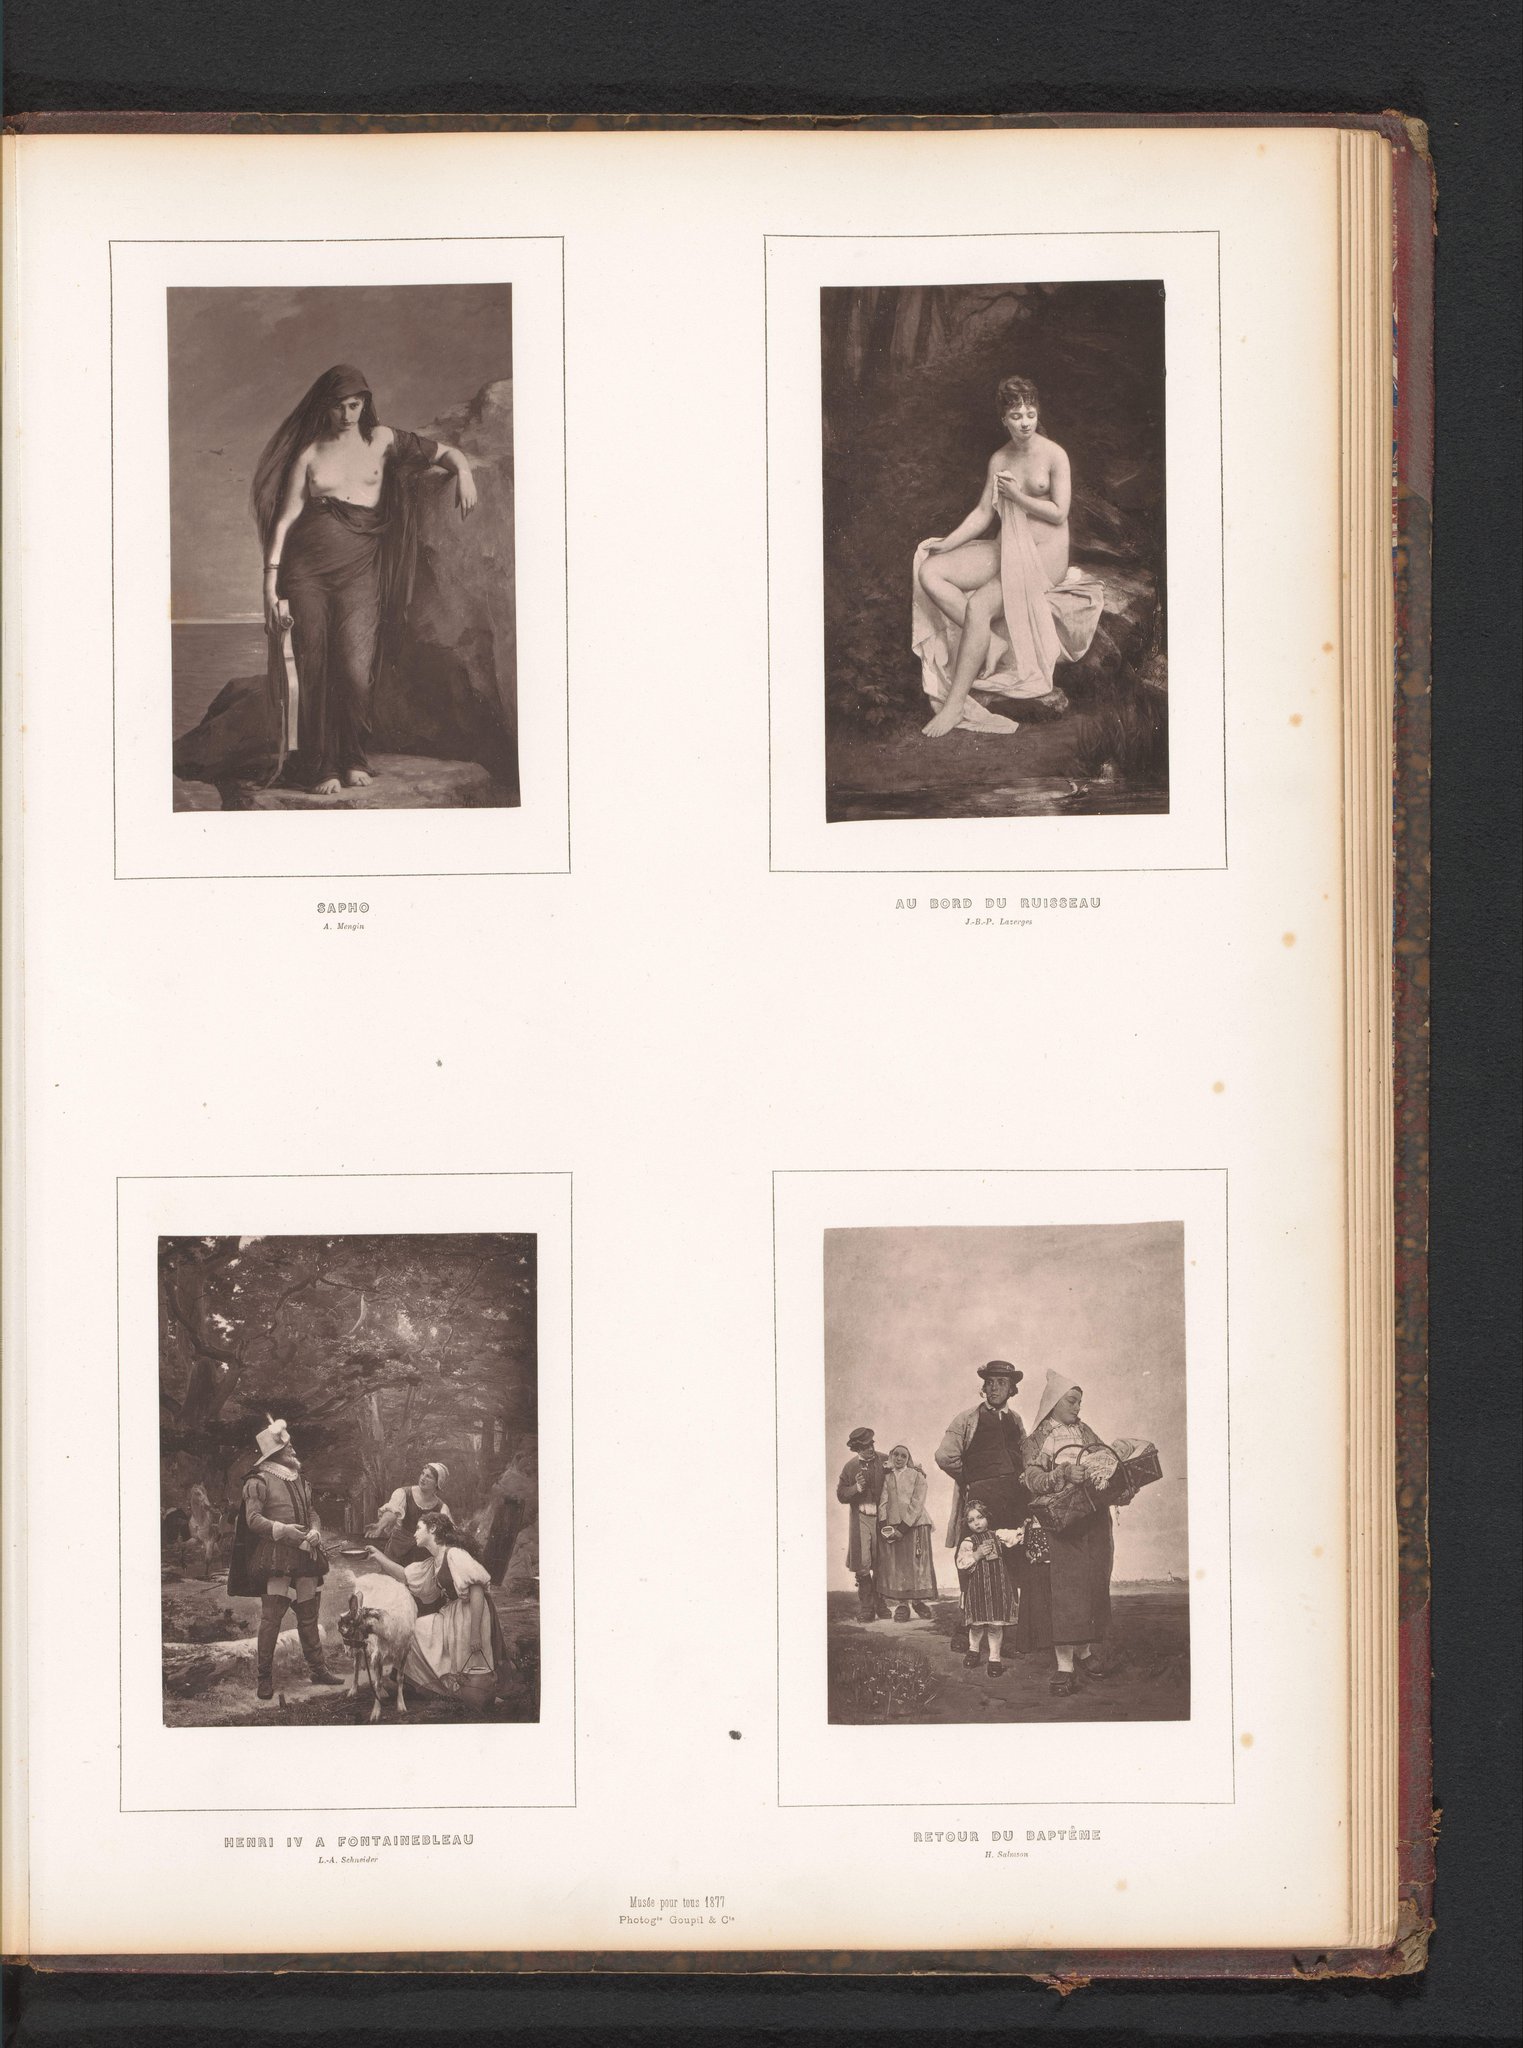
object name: page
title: Retour du baptême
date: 1872-1879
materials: paper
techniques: woodburytype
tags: (story of) sappho, the poetess, taking a bath - aa - in the open air (+ alone), baptism, christening ceremony ~ the first of the seven sacraments - qq - baptism in the open air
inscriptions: inscription: ‘Musée pour tous 1877’